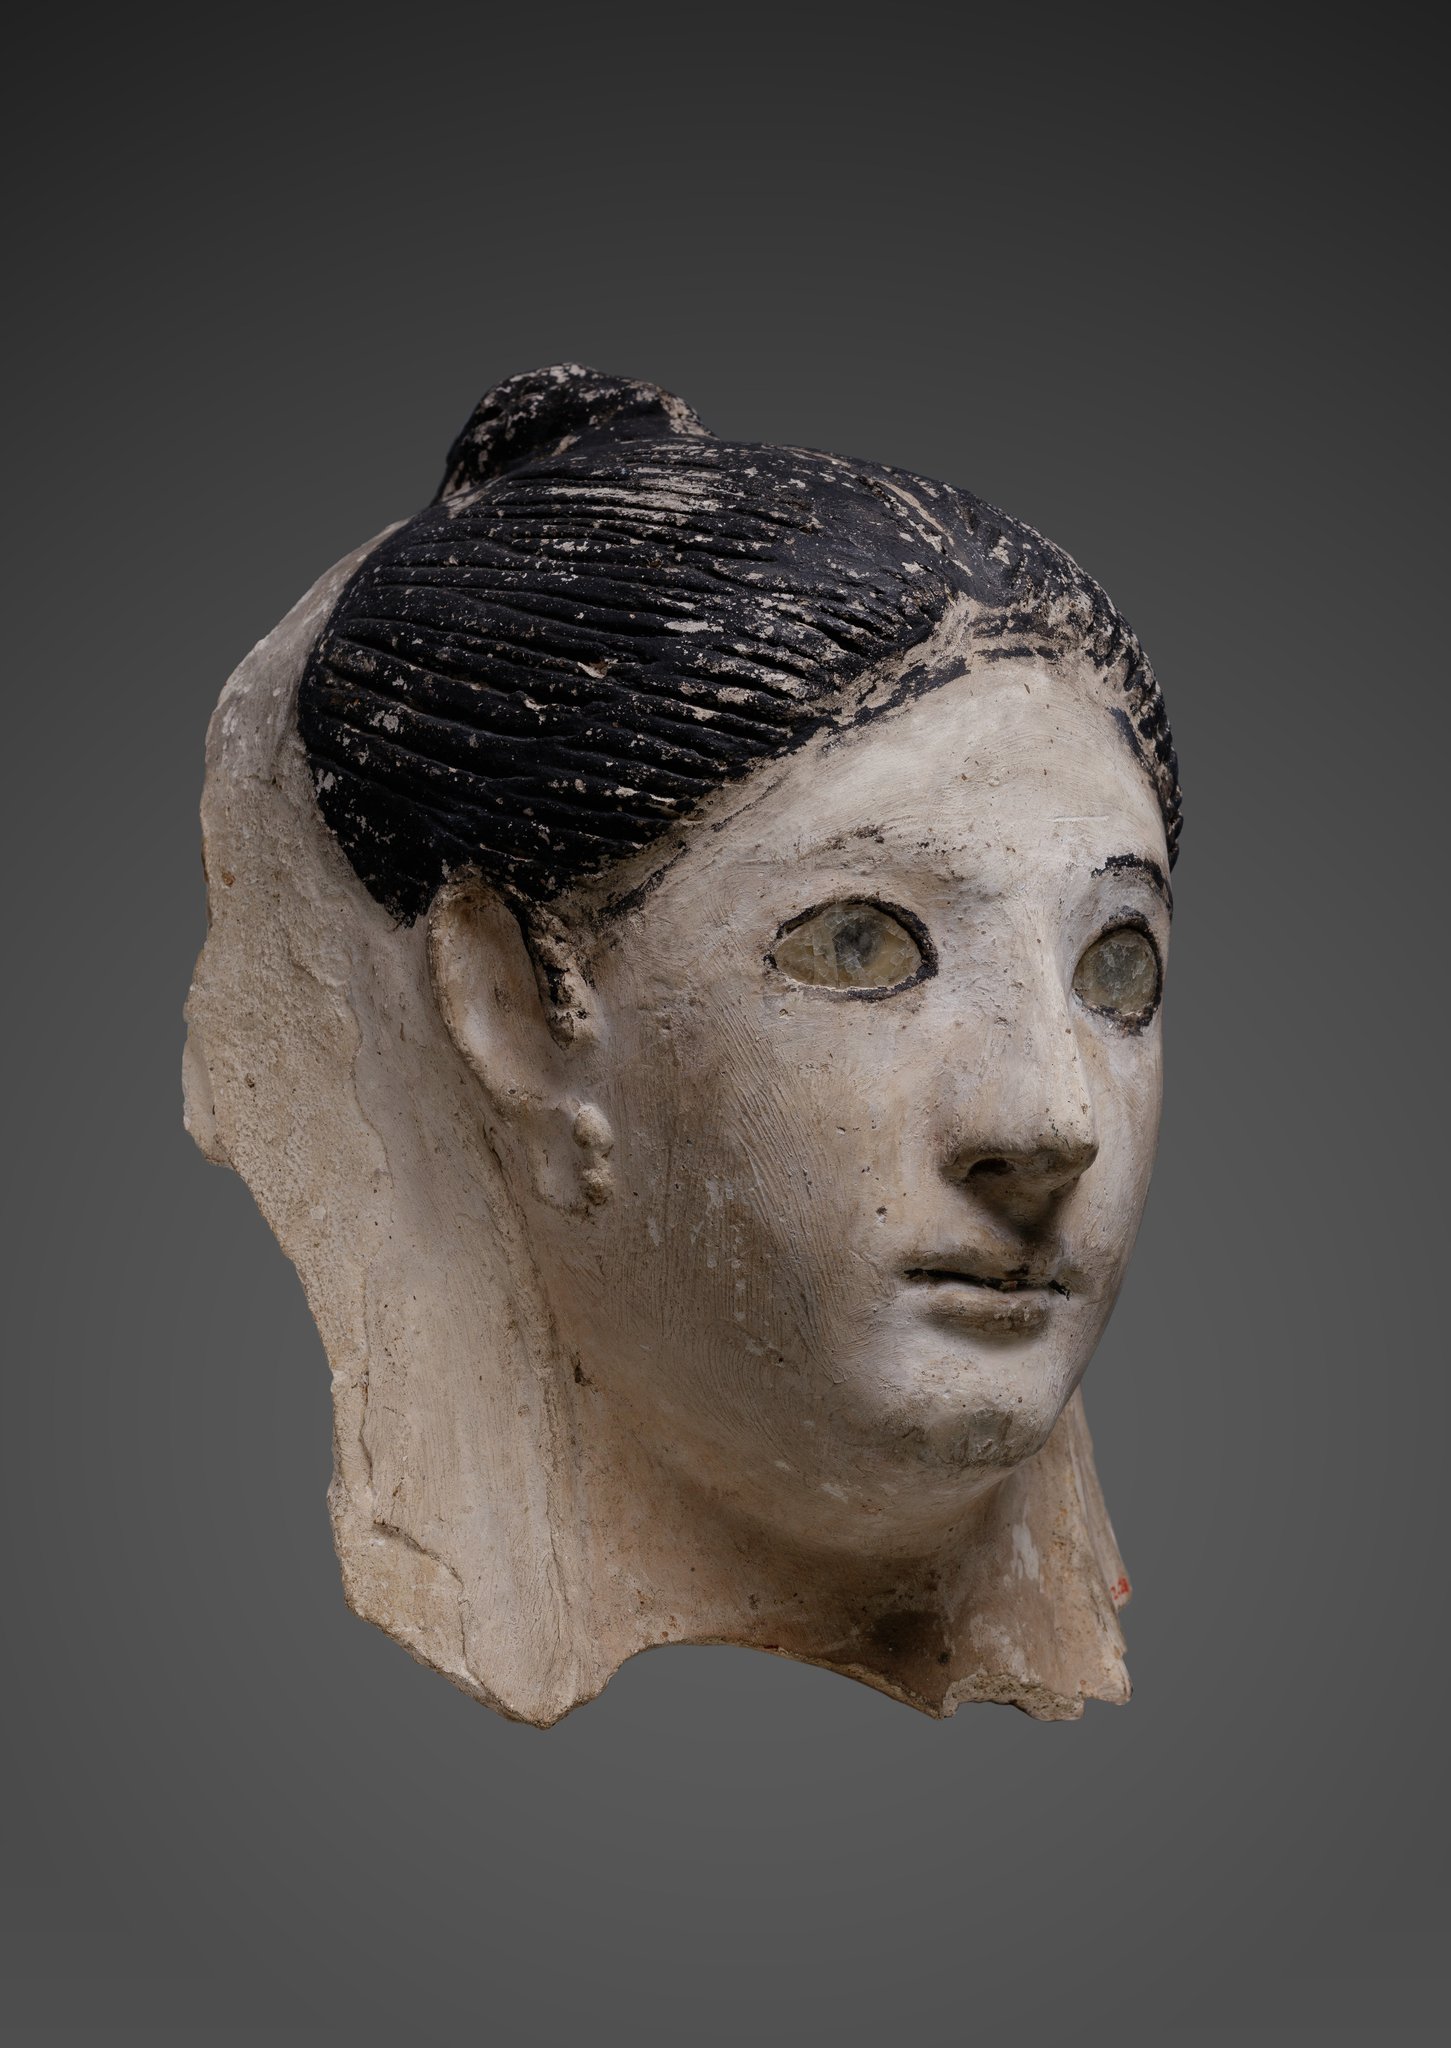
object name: mask, woman, hair in small knot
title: Mask of a woman with her hair in a small knot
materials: glass, paint, plaster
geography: egypt